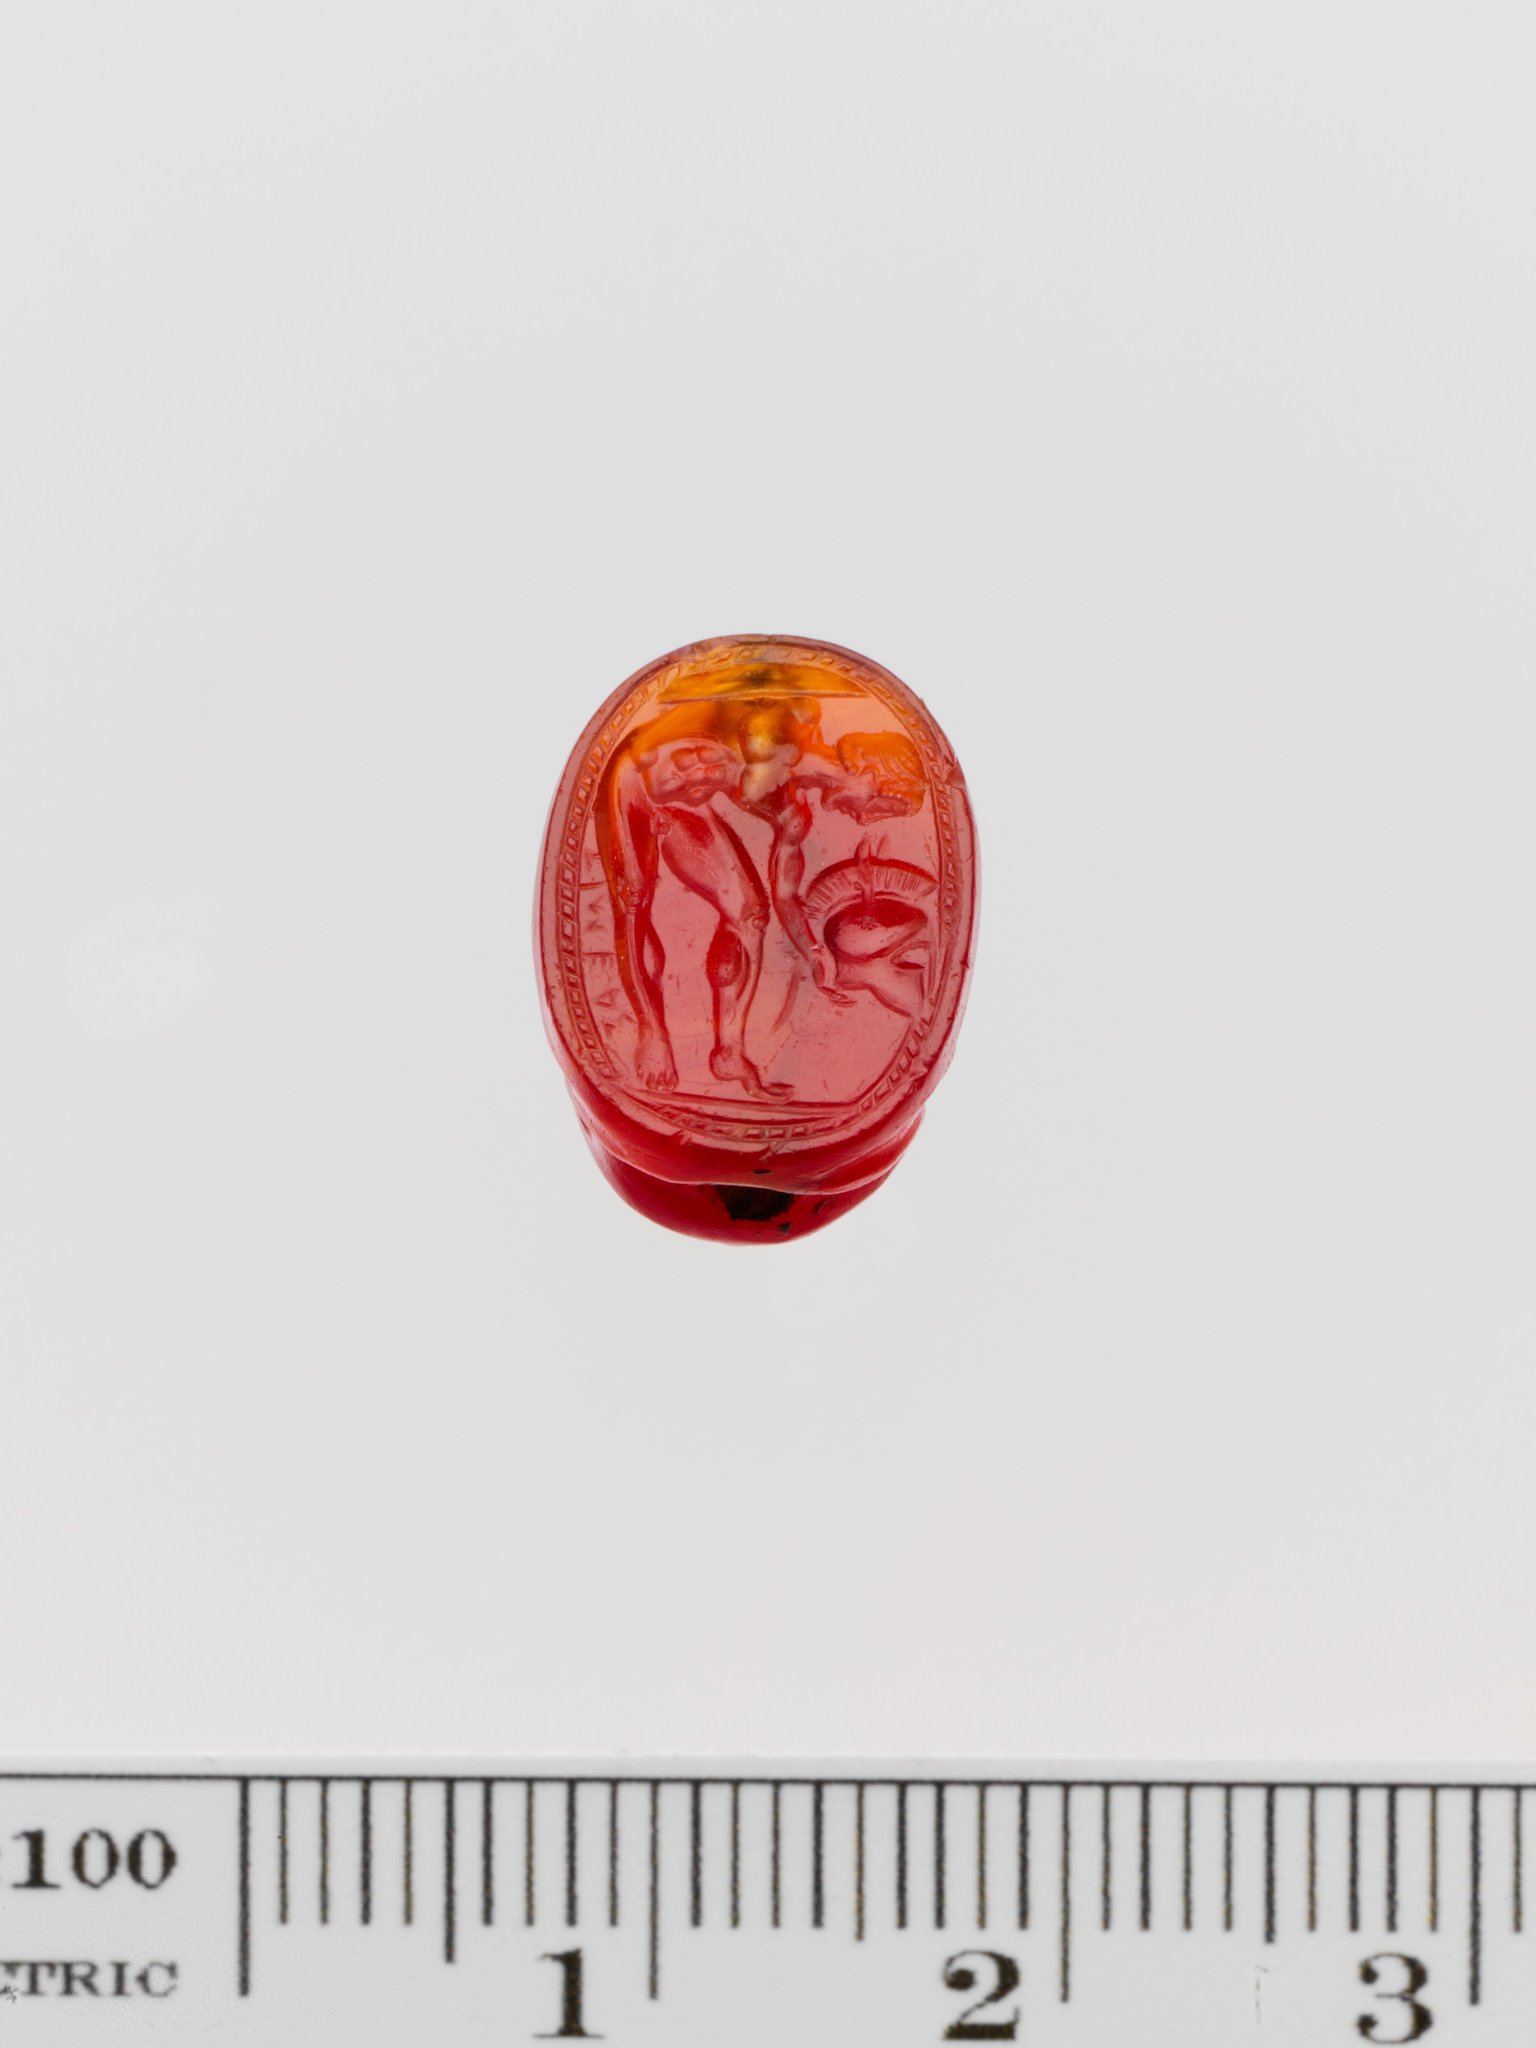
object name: scarab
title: Carnelian scarab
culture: greek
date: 500 BCE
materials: gemstone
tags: helmets,men,scarabs